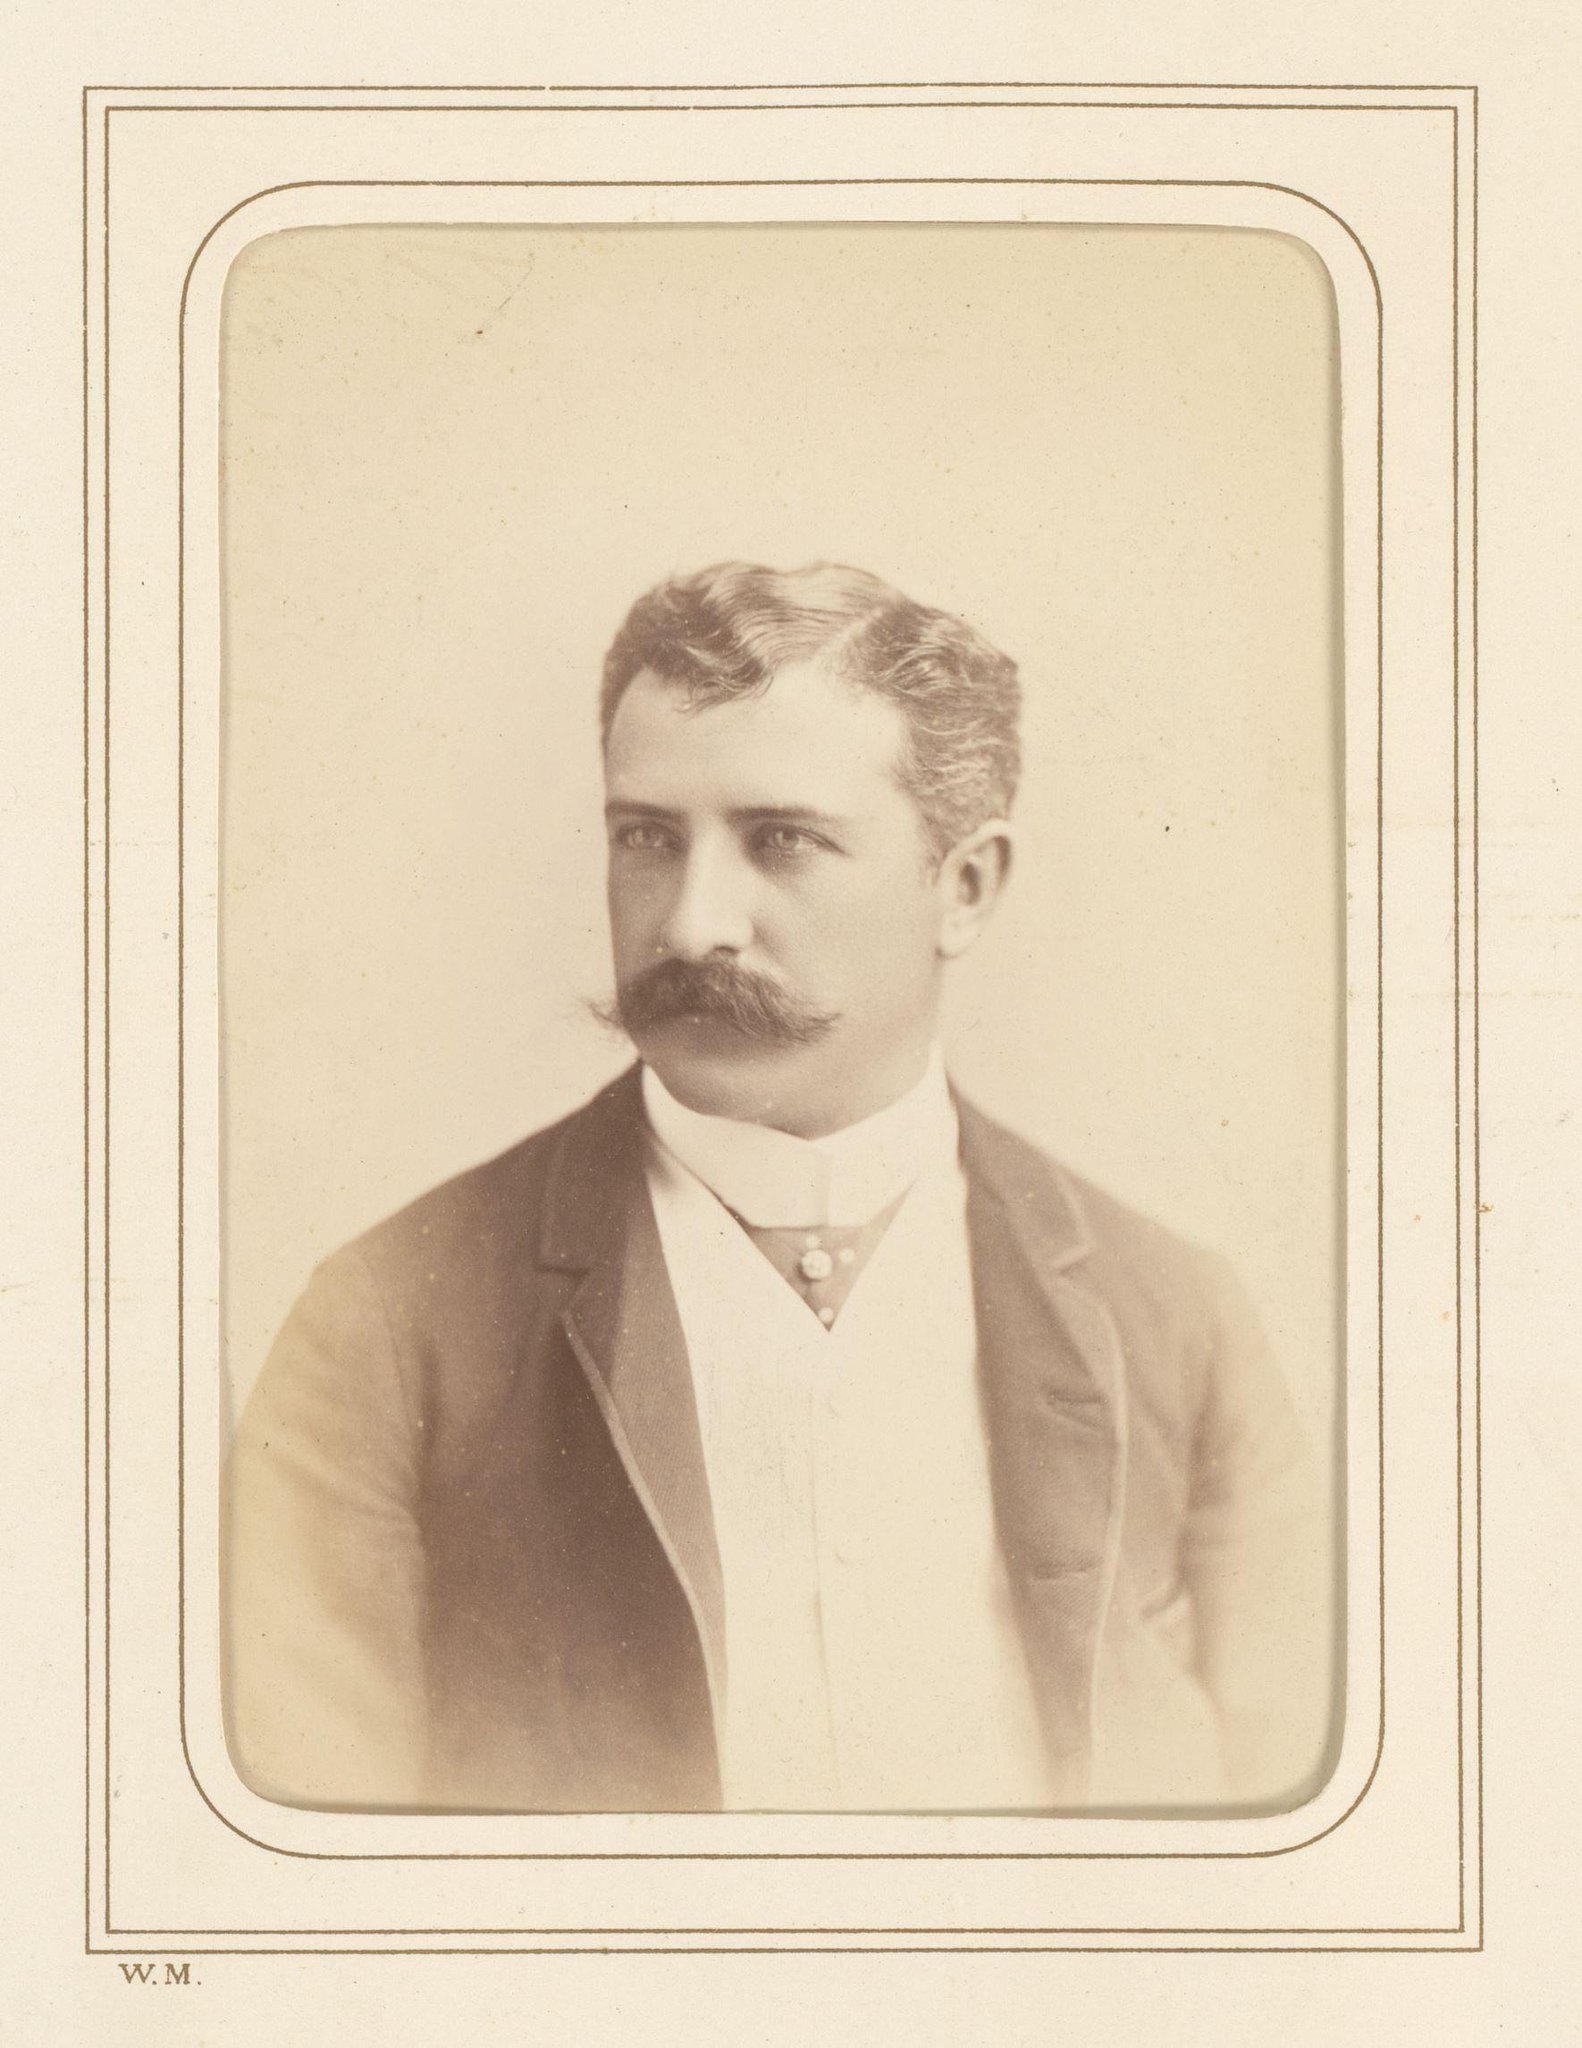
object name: photograph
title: Portret van een acteur, aangeduid als R. Lanze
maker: hora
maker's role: fotograaf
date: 1875-1899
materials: cardboard, photographic support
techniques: albumen print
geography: new york city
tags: historical persons, portrait of actor, actress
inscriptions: annotation: ‘Recuerdo de Paris/ a mi [.]ueri amigo J. Oppenheimer/ Marzo 17 1889/ R. Lanze’, inscription: ‘Hora/ 707 BROADWAY, N. Y.’